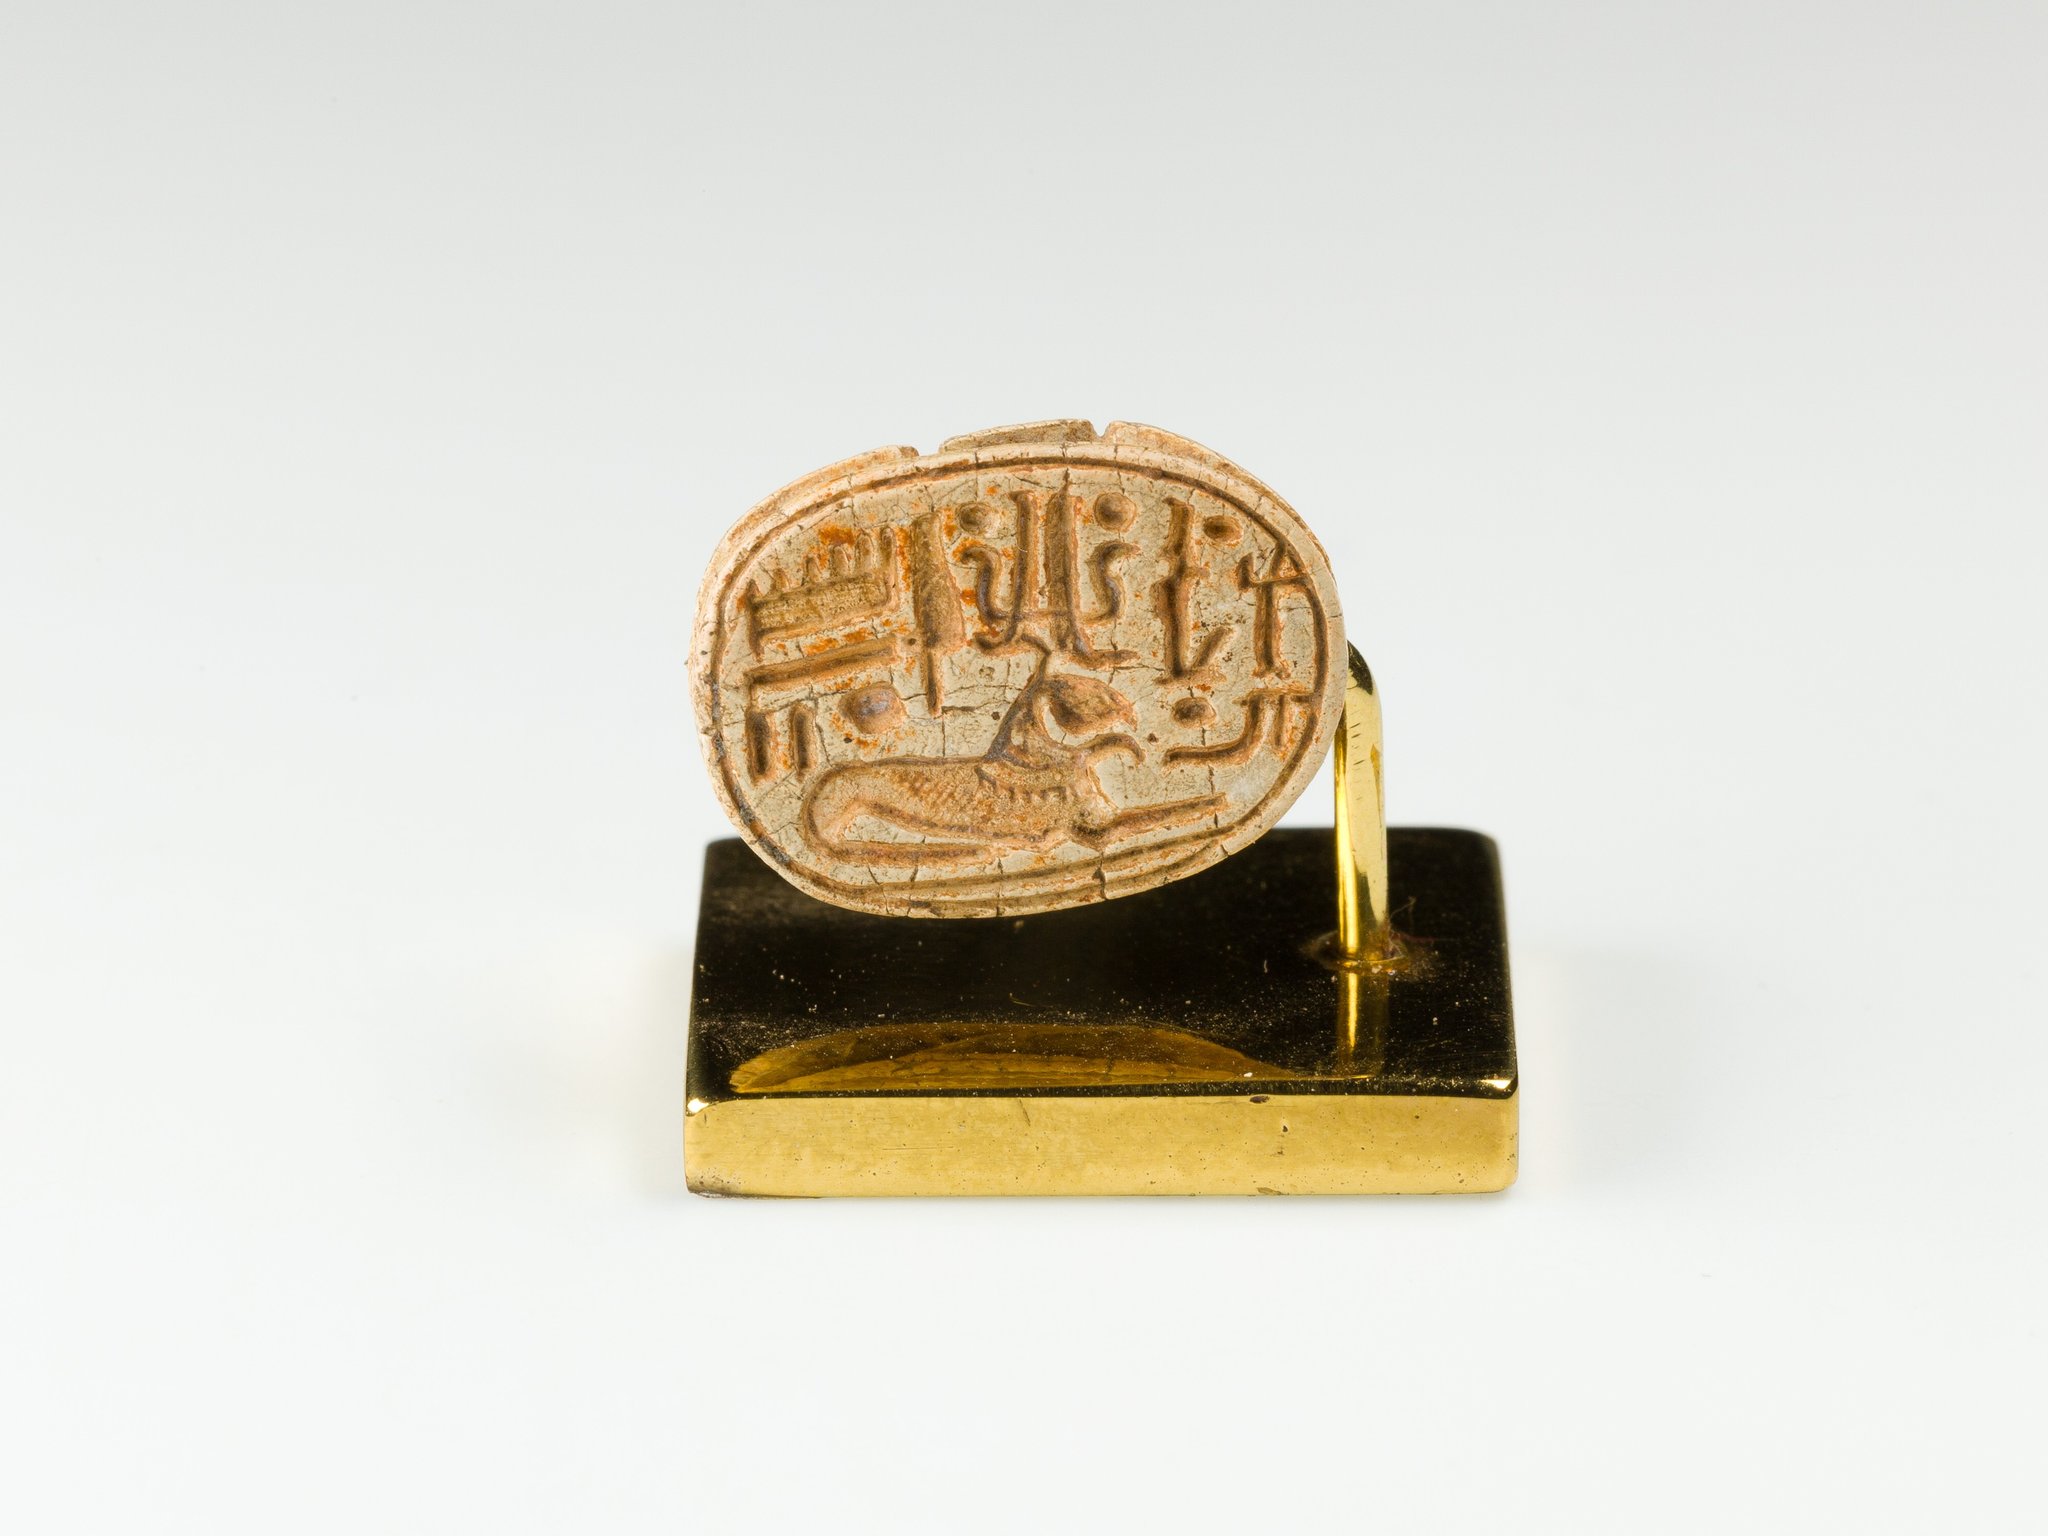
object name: scarab, ramesses ii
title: Scarab of Ramesses II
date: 1295-1070 BCE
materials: stone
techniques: glazing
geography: egypt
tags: scarabs